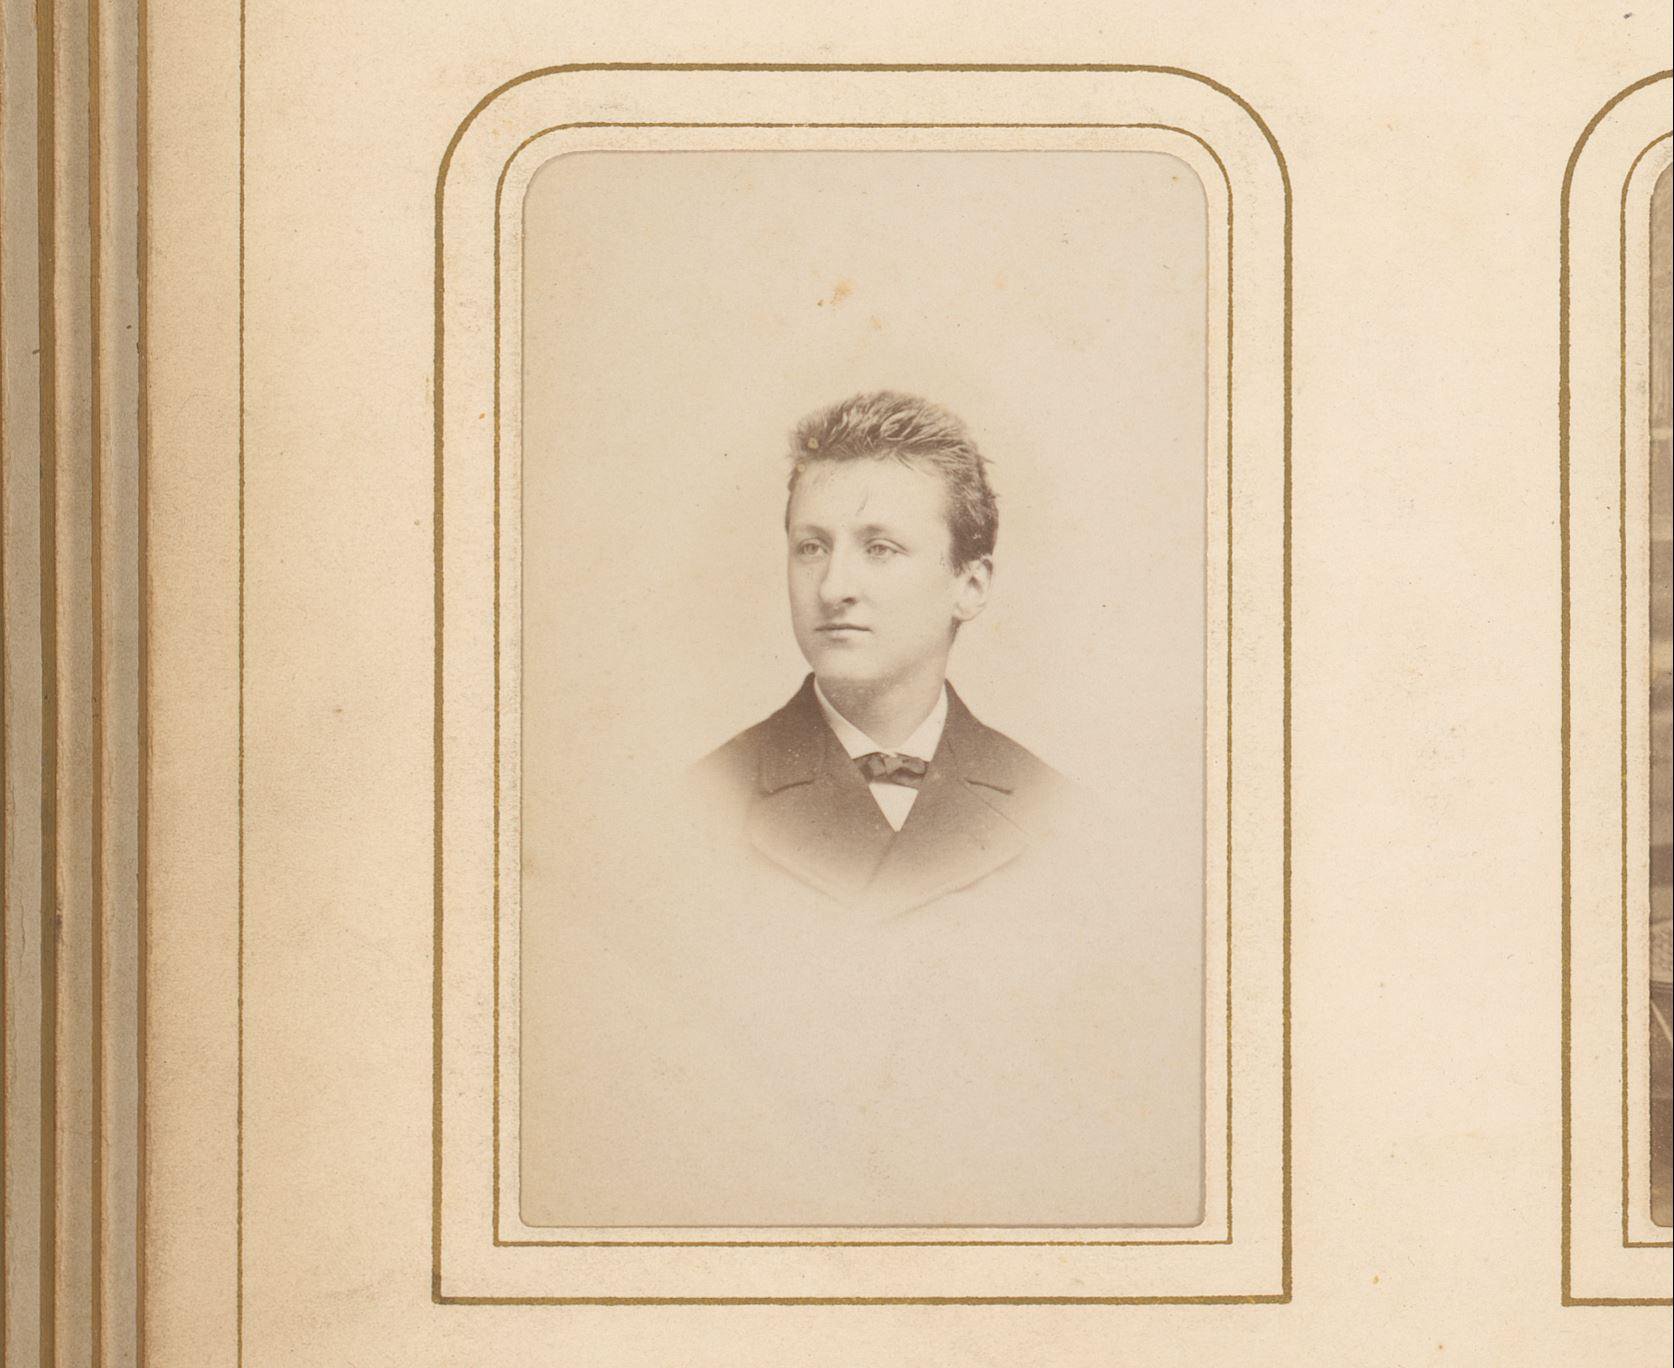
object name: photograph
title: Portret van een jonge man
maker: eugene guérin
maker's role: fotograaf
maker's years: 1845-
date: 1878-1885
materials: cardboard, photographic support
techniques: albumen print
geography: brussels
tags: historical persons, youth, adolescent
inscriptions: inscription: ‘MÉDAILLE D'OR NAPLES 1874/ MENTION HONORABLE EXPon UNIVle PARIS 1878/ Eugène Guérin/ 142, Rue Royale, 142/ Bruxelles’